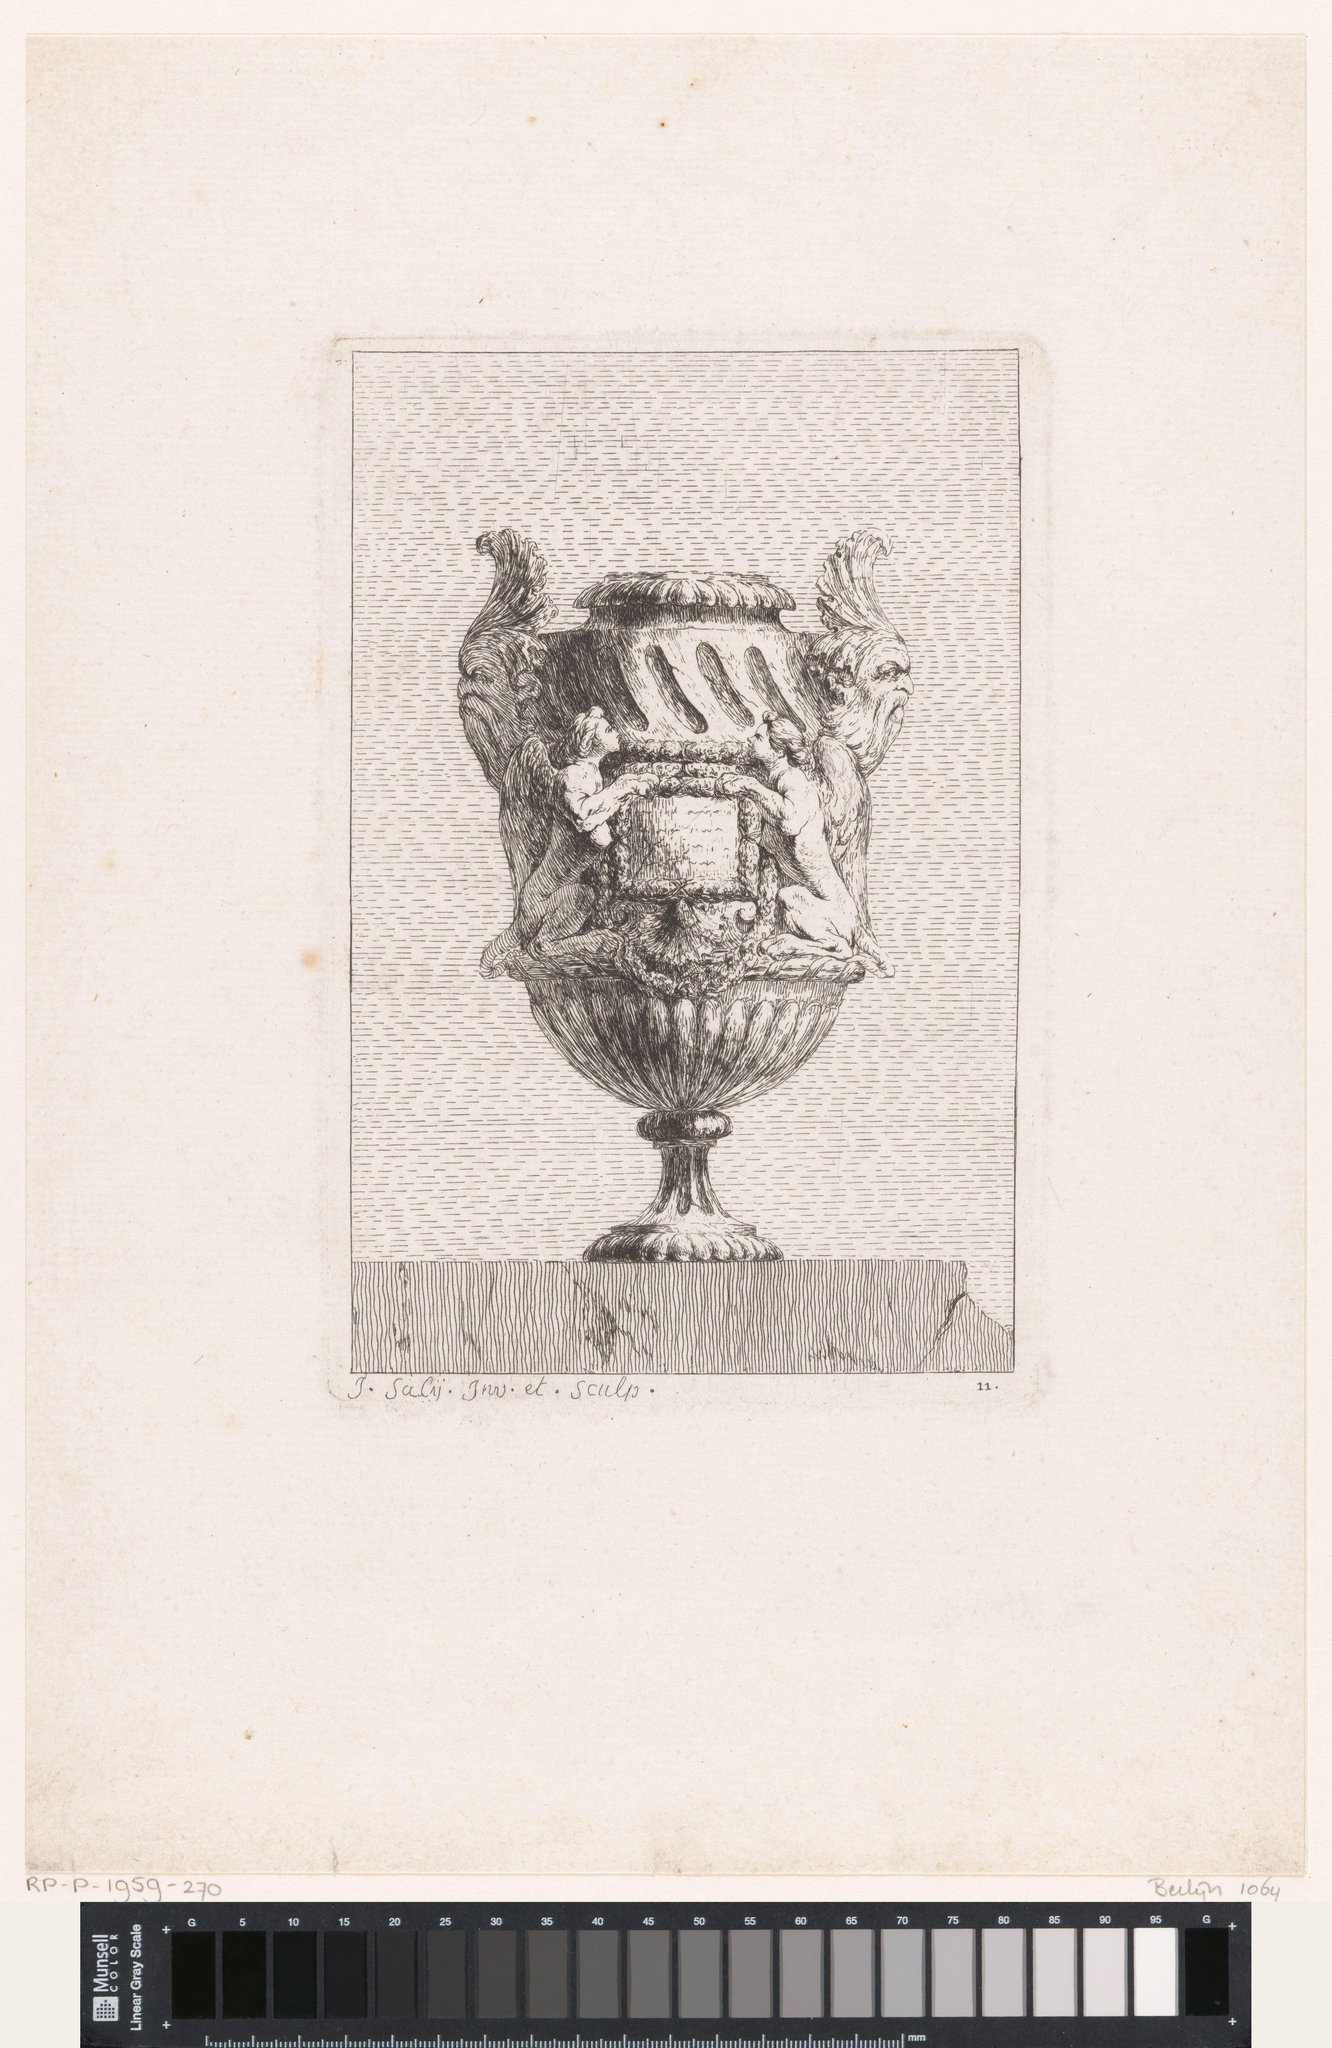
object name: print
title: Vaas met sfinxen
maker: jacques francois joseph saly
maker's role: print maker, sculptor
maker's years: 1717-1776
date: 1746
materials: paper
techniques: etching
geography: france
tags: sphinx (lion/woman); 'sfinge' (ripa), mask, mascaron ~ ornament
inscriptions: collector's mark: Lugt 2228, collector's mark: Lugt 2760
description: Een geornamenteerde vaas met twee zittende sfinxen en twee maskers met baard.